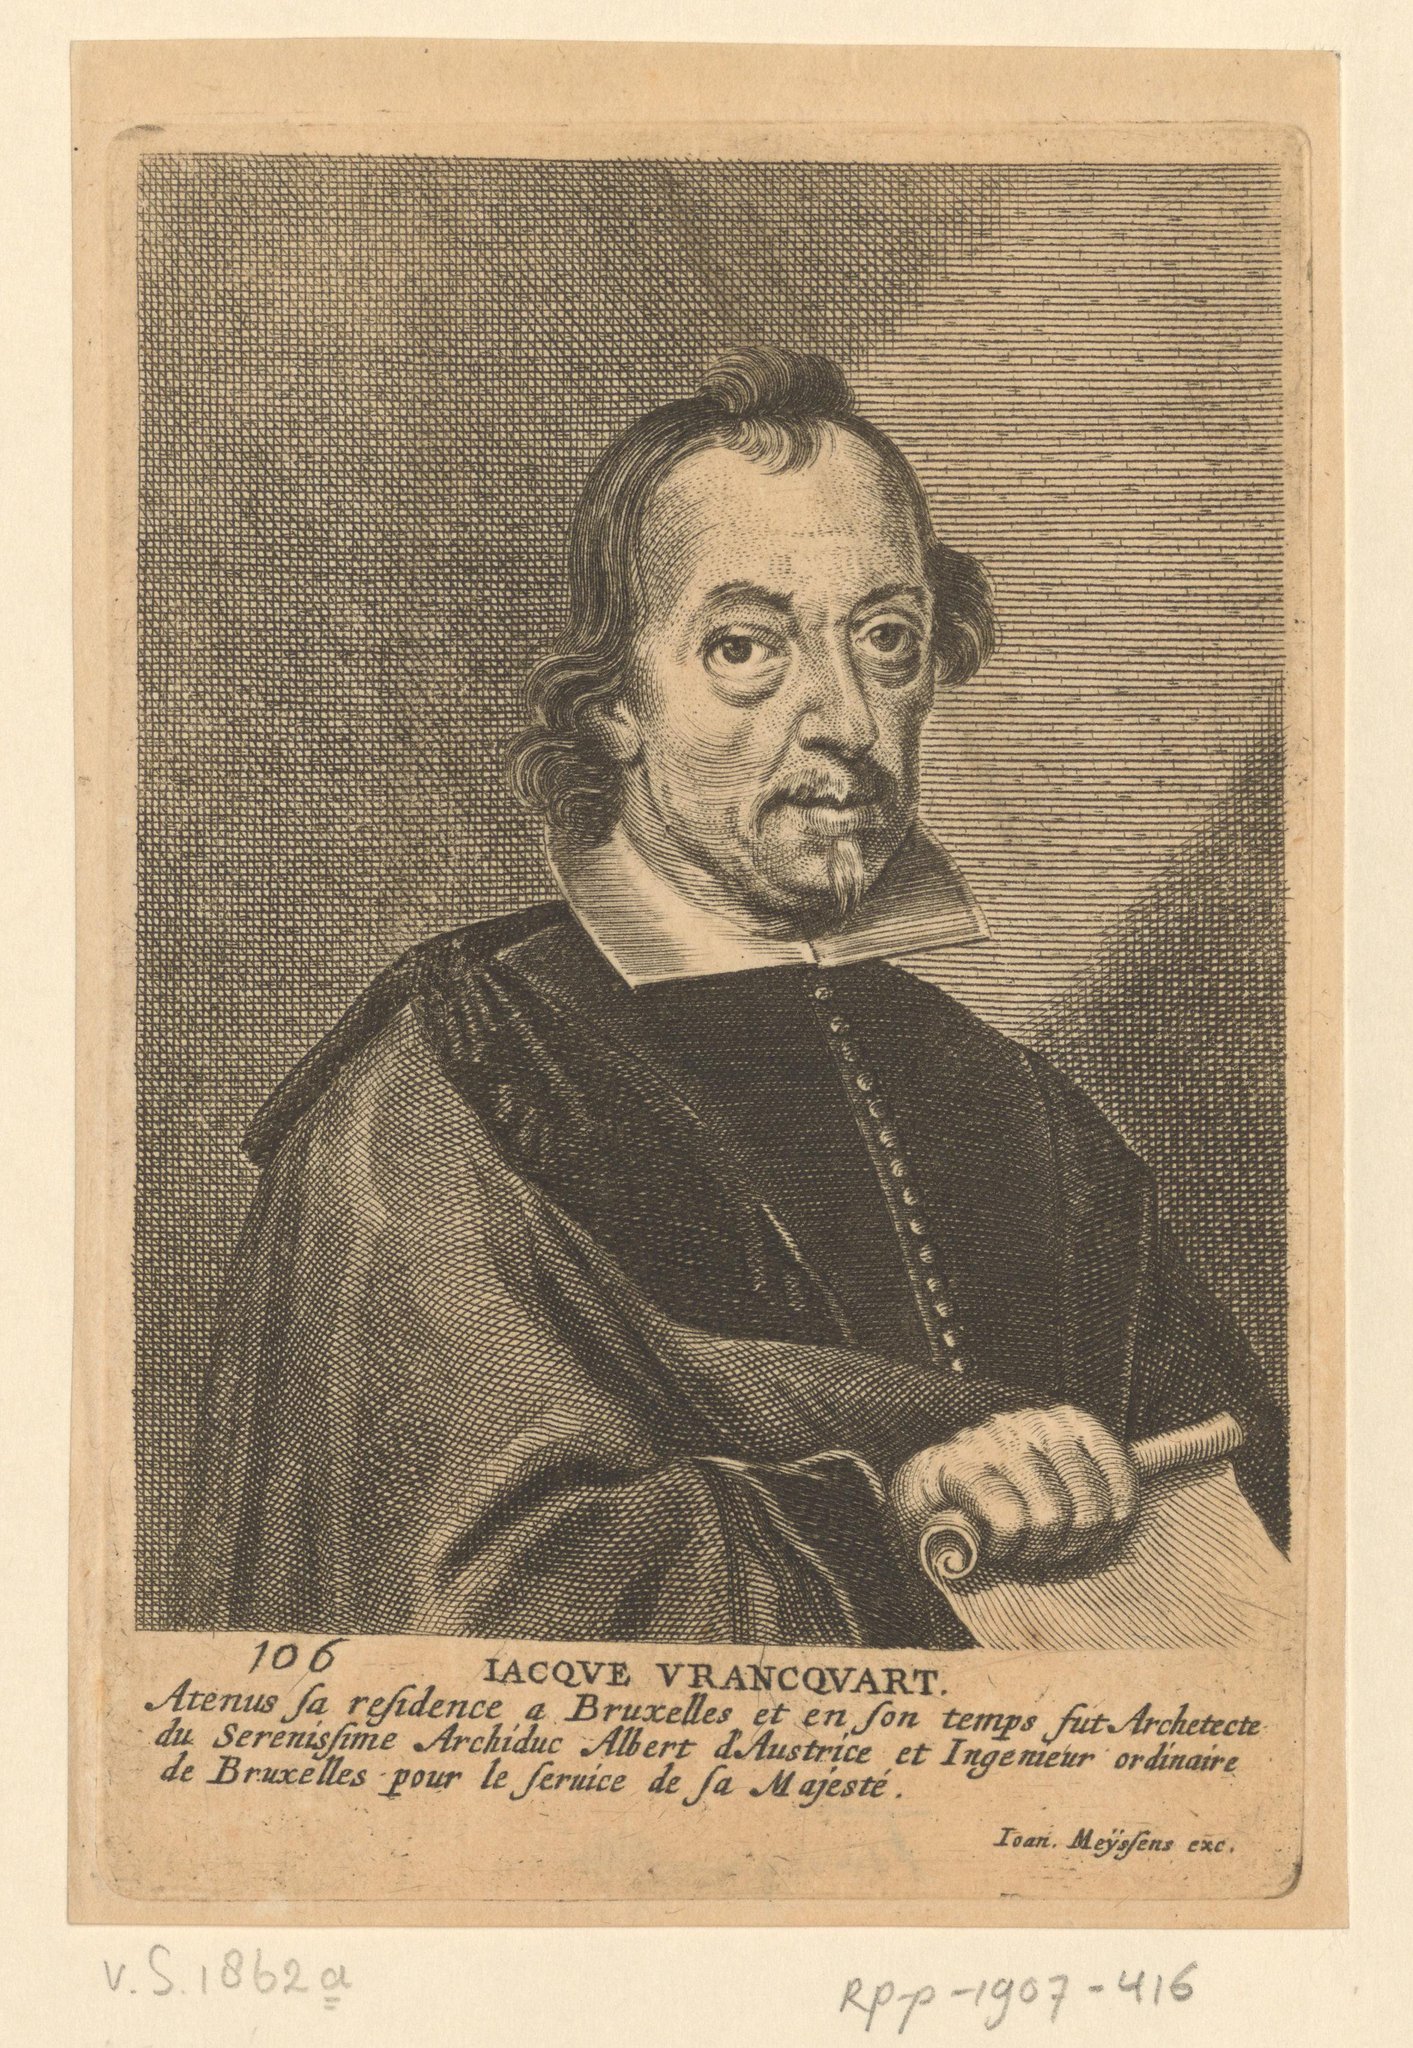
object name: print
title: Portret van Jacques Franckaert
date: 1640-1670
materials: paper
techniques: etching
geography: antwerp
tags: brussels, jacques franckaert (ii), historical persons, portrait, self-portrait of artist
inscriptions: collector's mark: Lugt 2228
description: Linksonder genummerd: 106. Met onderschrift in het Frans.